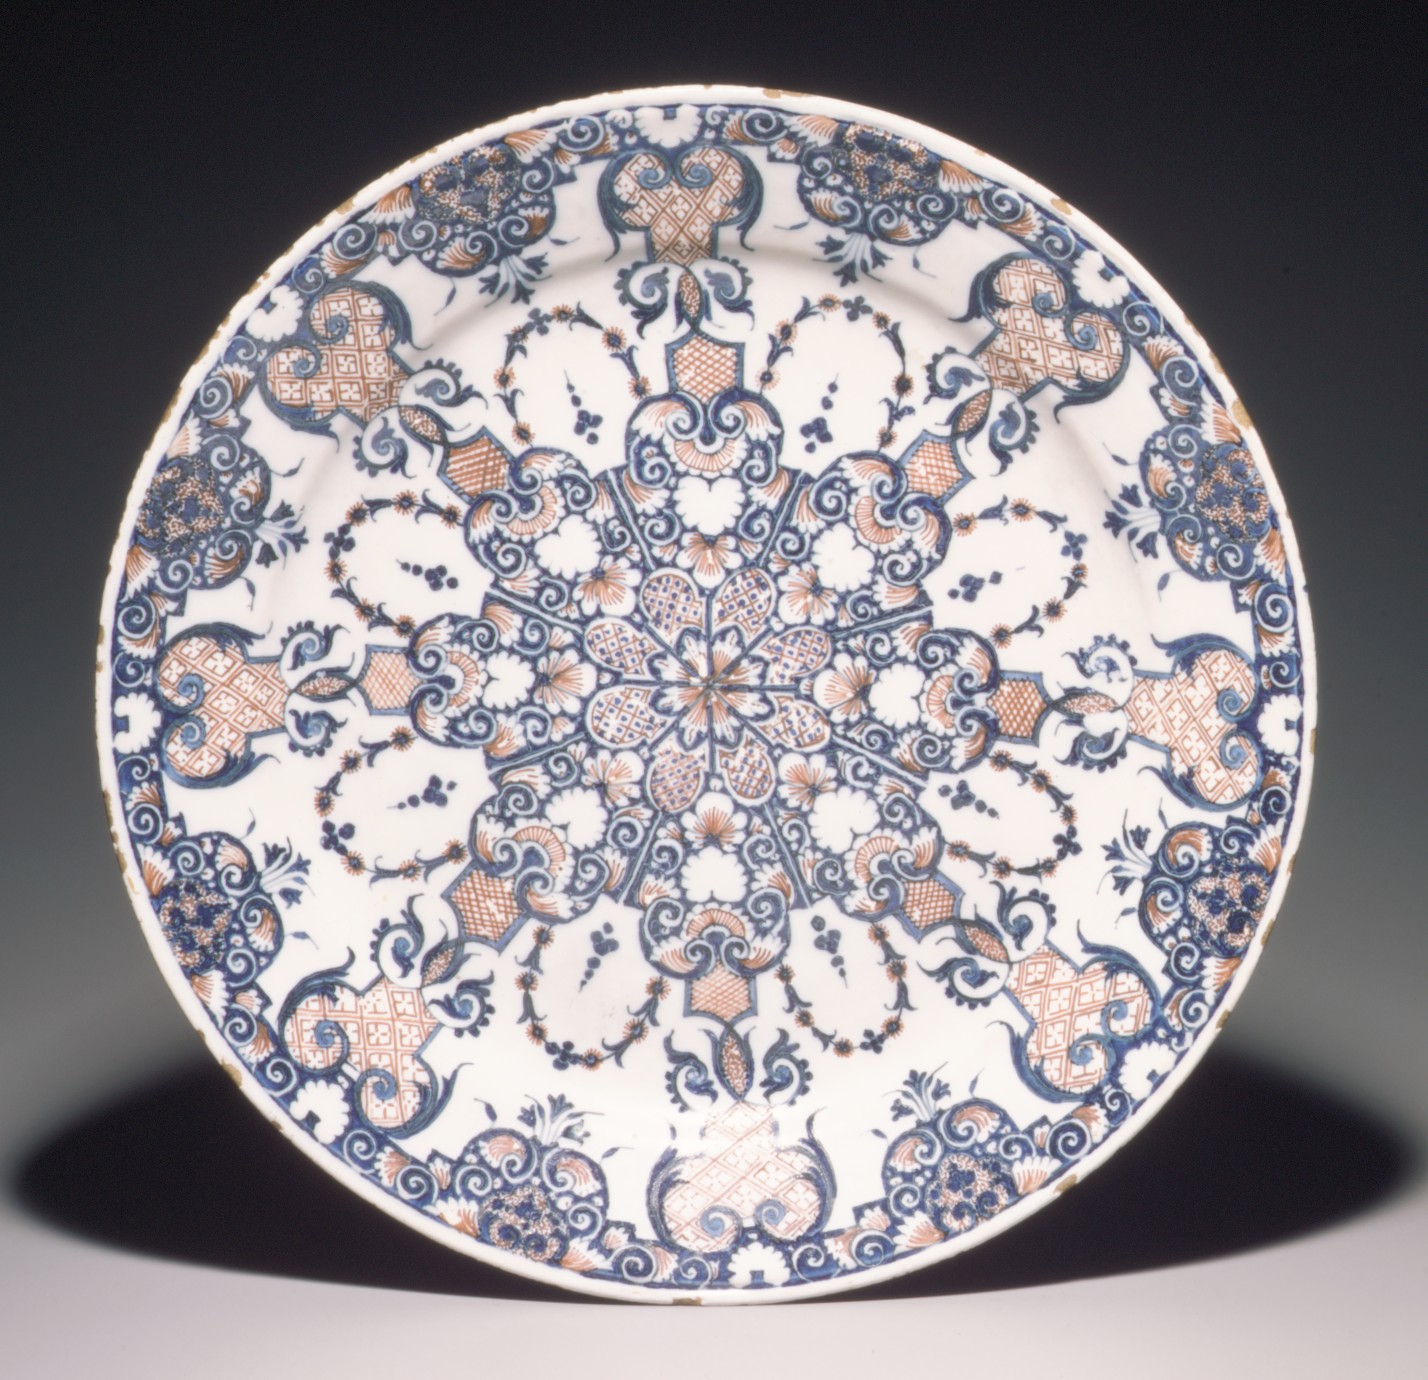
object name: plate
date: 1720-1730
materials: faience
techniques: glazing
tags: flowers